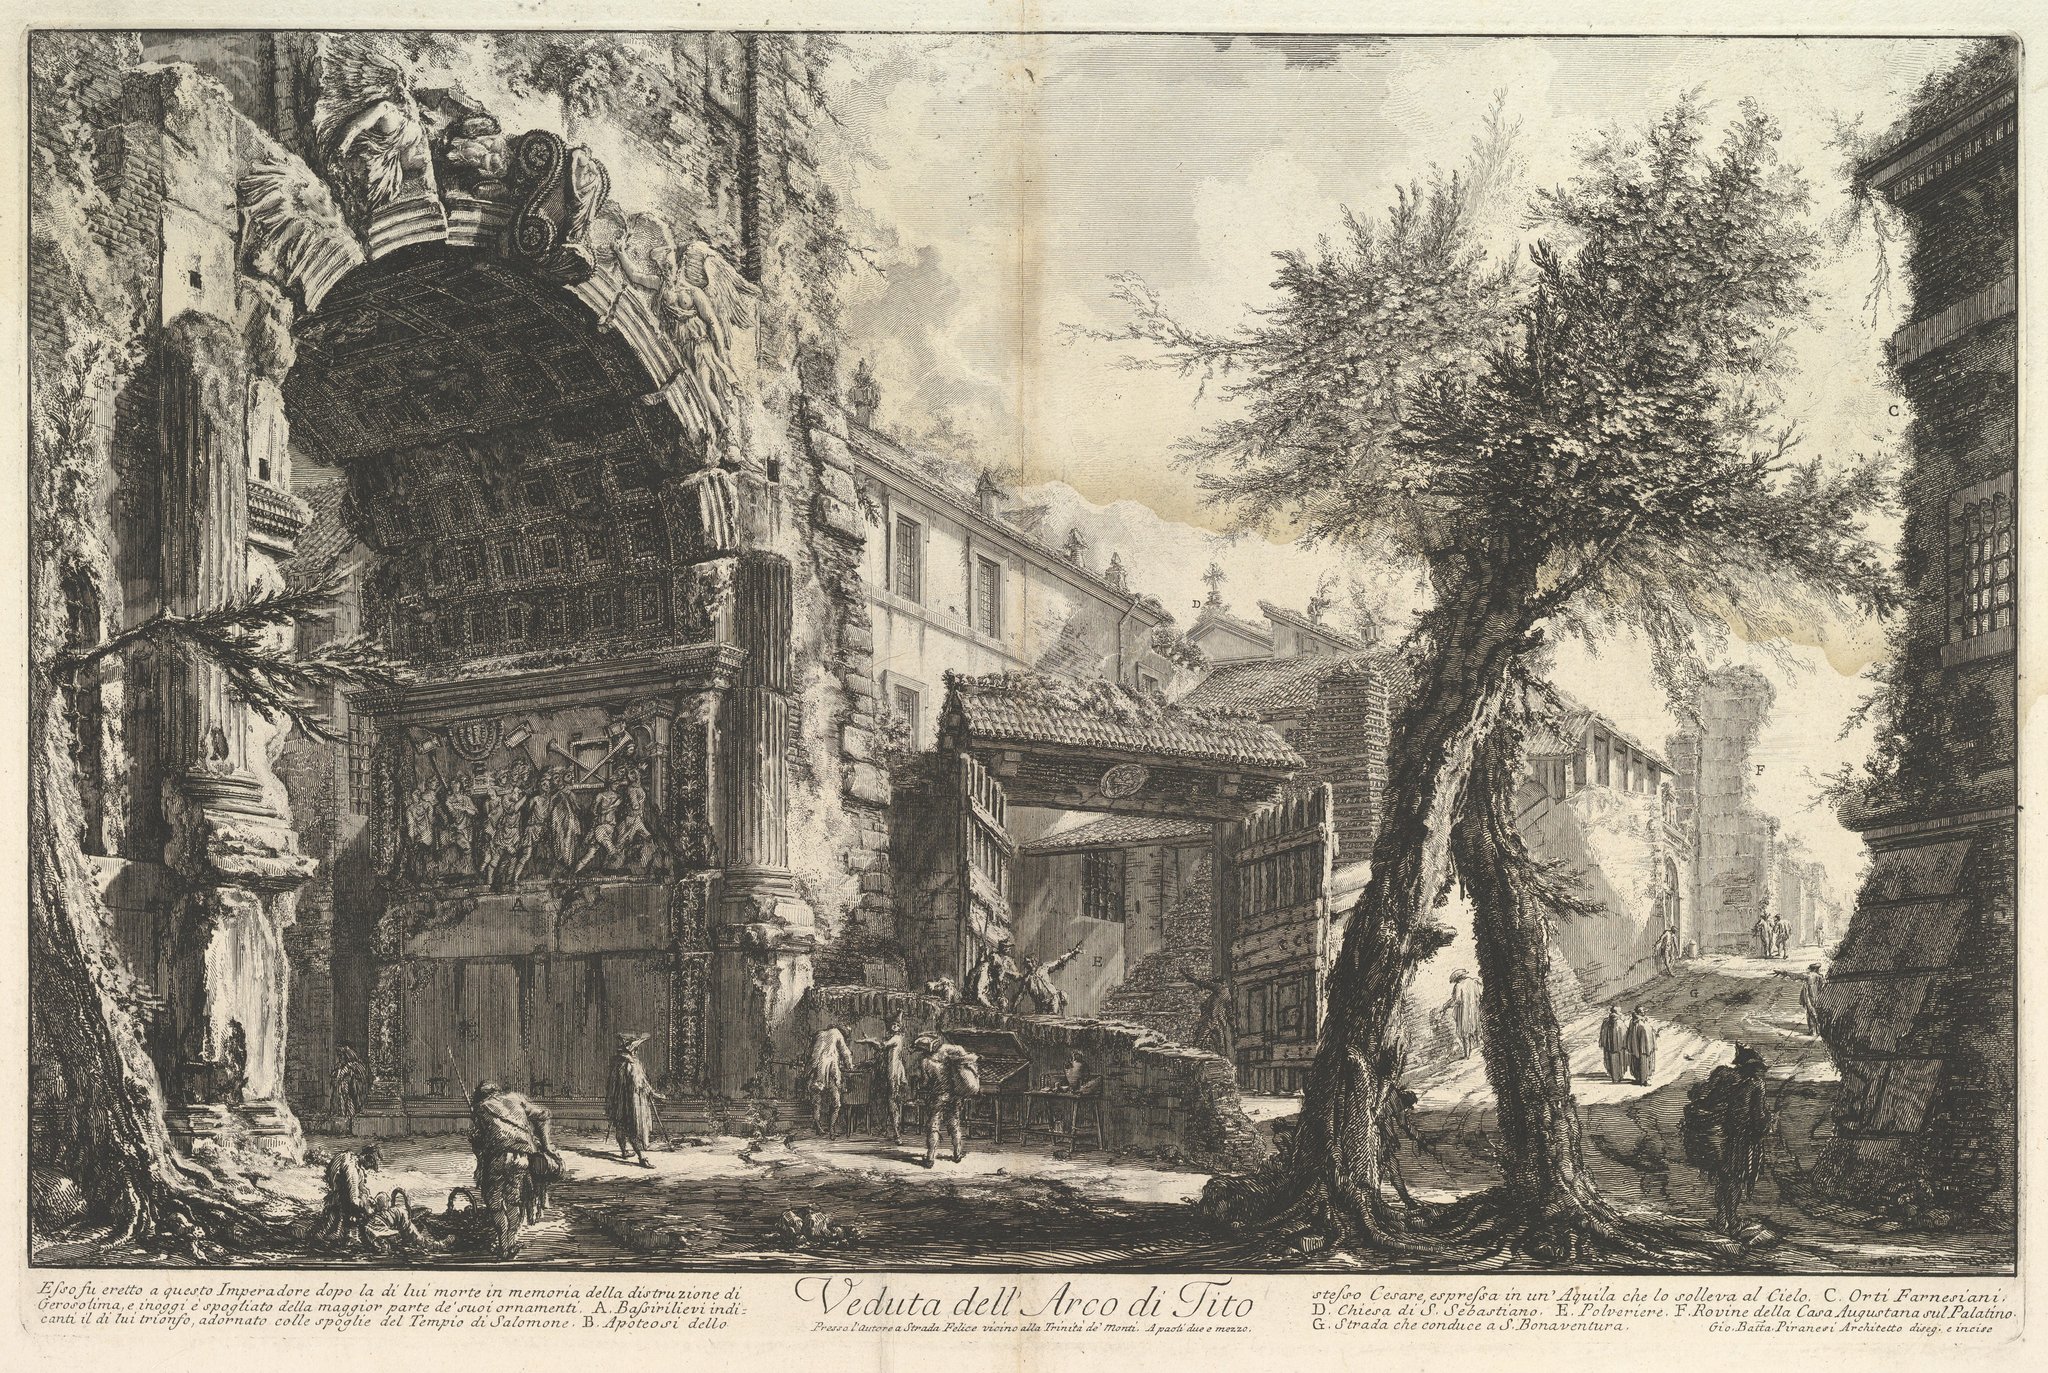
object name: print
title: The Arch of Titus (Veduta dell'Arco di Tito)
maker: giovanni battista piranesi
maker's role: artist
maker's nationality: italian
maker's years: 1720-1778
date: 1760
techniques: etching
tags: arches,ruins